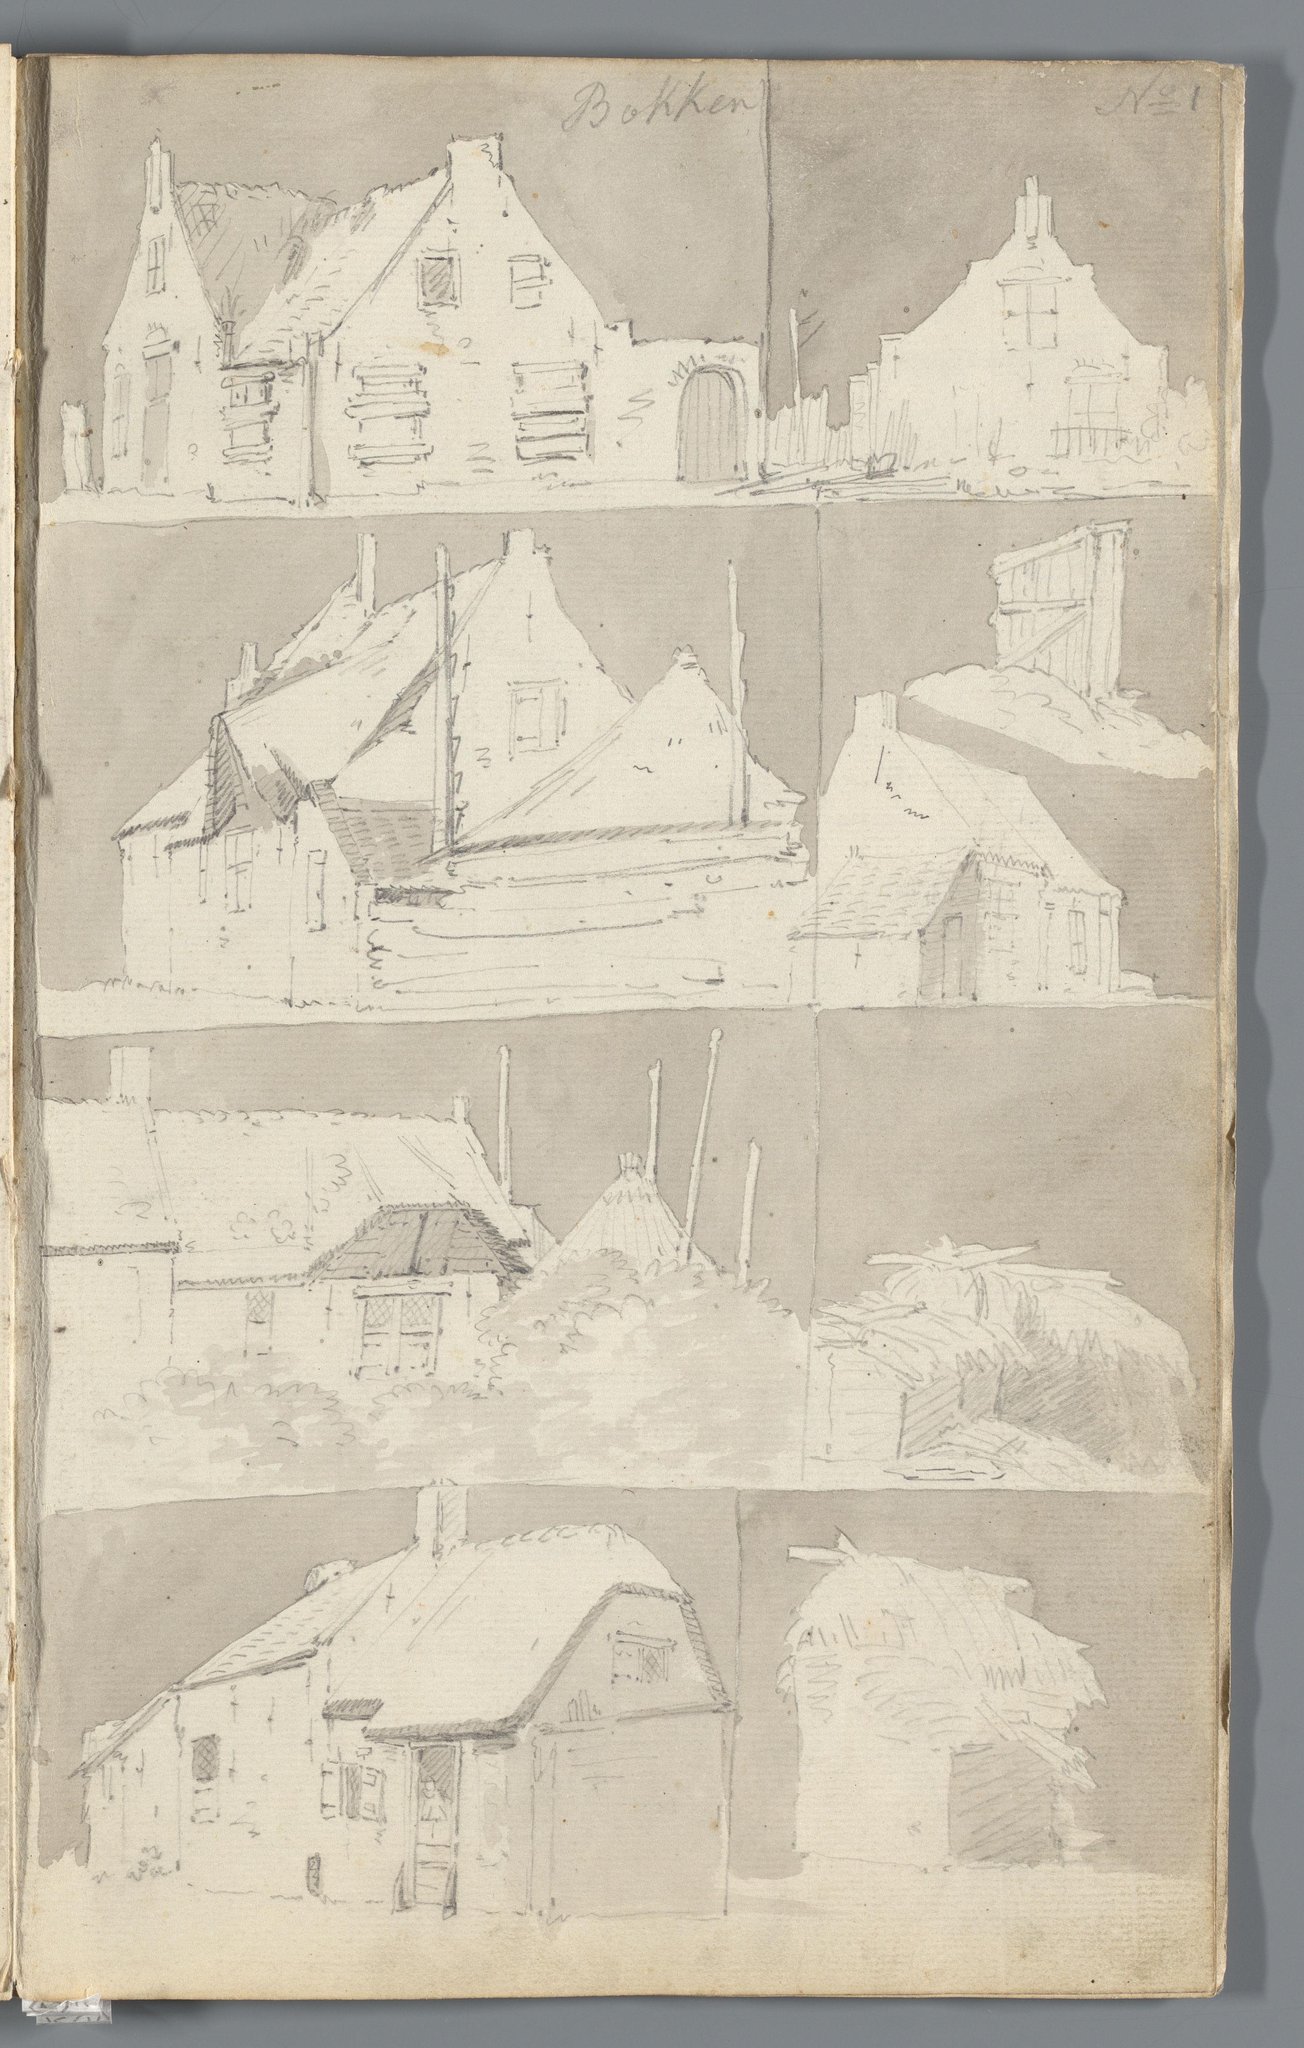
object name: sketchbook leaf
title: Boerderijen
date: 1780-1800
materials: ink, paper, pencil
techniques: brush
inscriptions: inscription: ‘No 1’, inscription: ‘Bokken’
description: Blad 4 recto uit een schetsboek met 17 bladen.